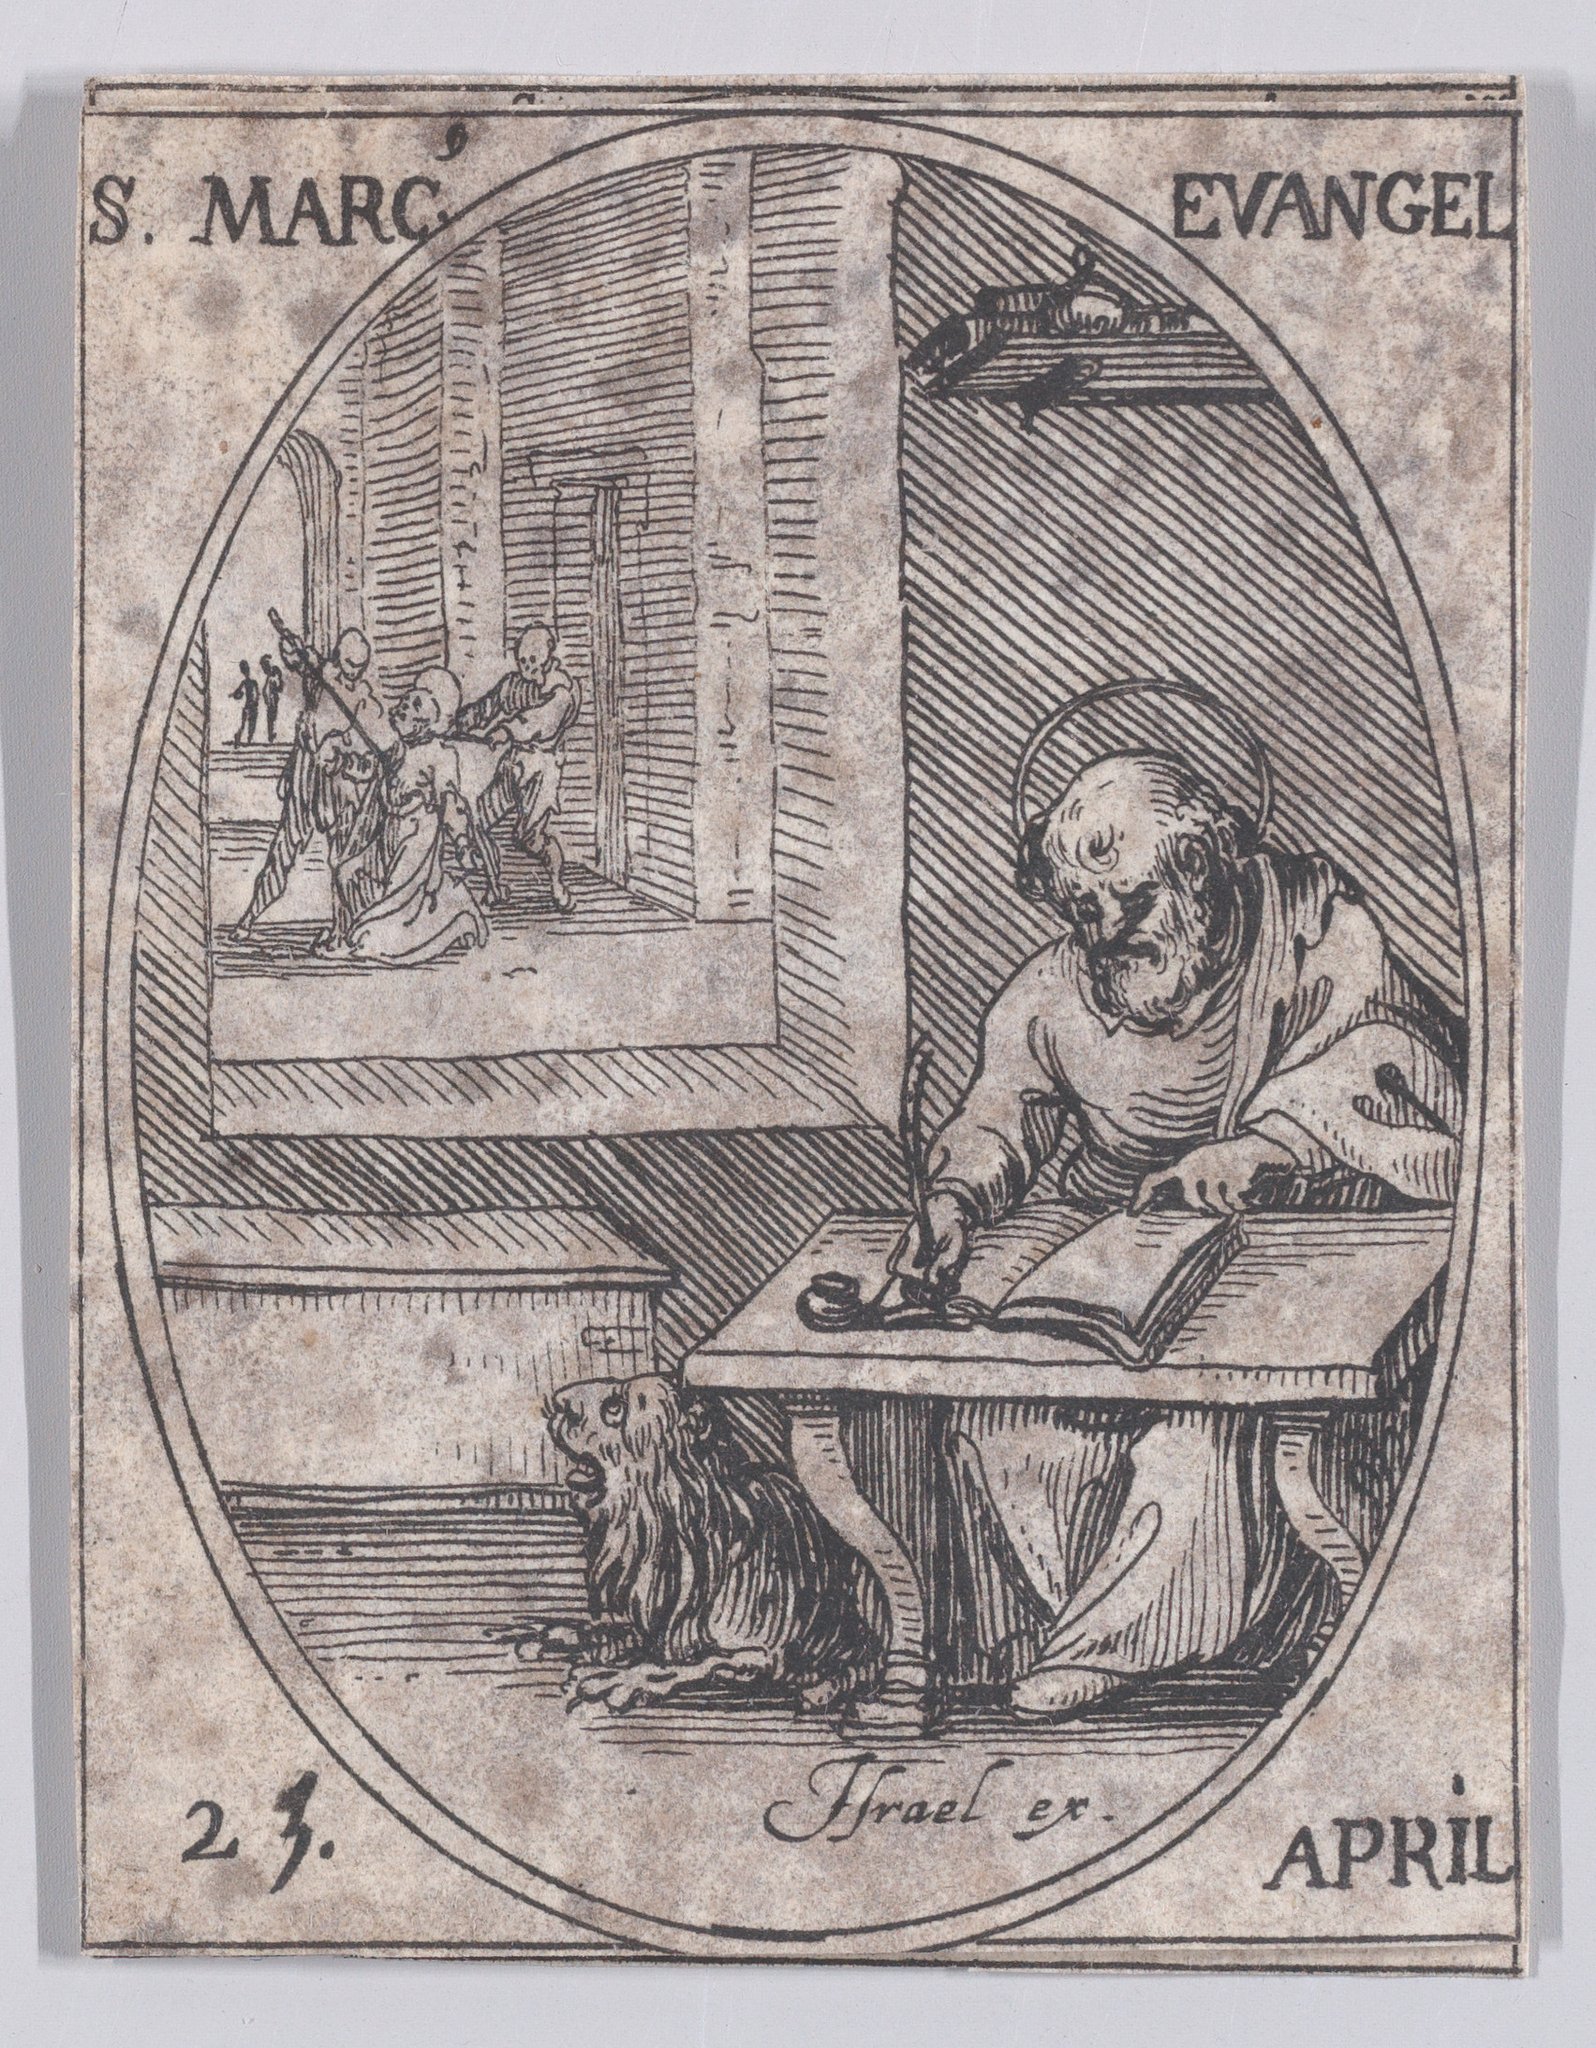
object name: print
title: S. Marc, évangéliste (St. Mark, Evangelist), April 25th, from "Les Images De Tous Les Saincts et Saintes de L'Année" (Images of All of the Saints and Religious Events of the Year)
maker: jacques callot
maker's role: artist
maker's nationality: french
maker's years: 1592-1635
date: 1636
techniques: etching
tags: men,lions,saint mark